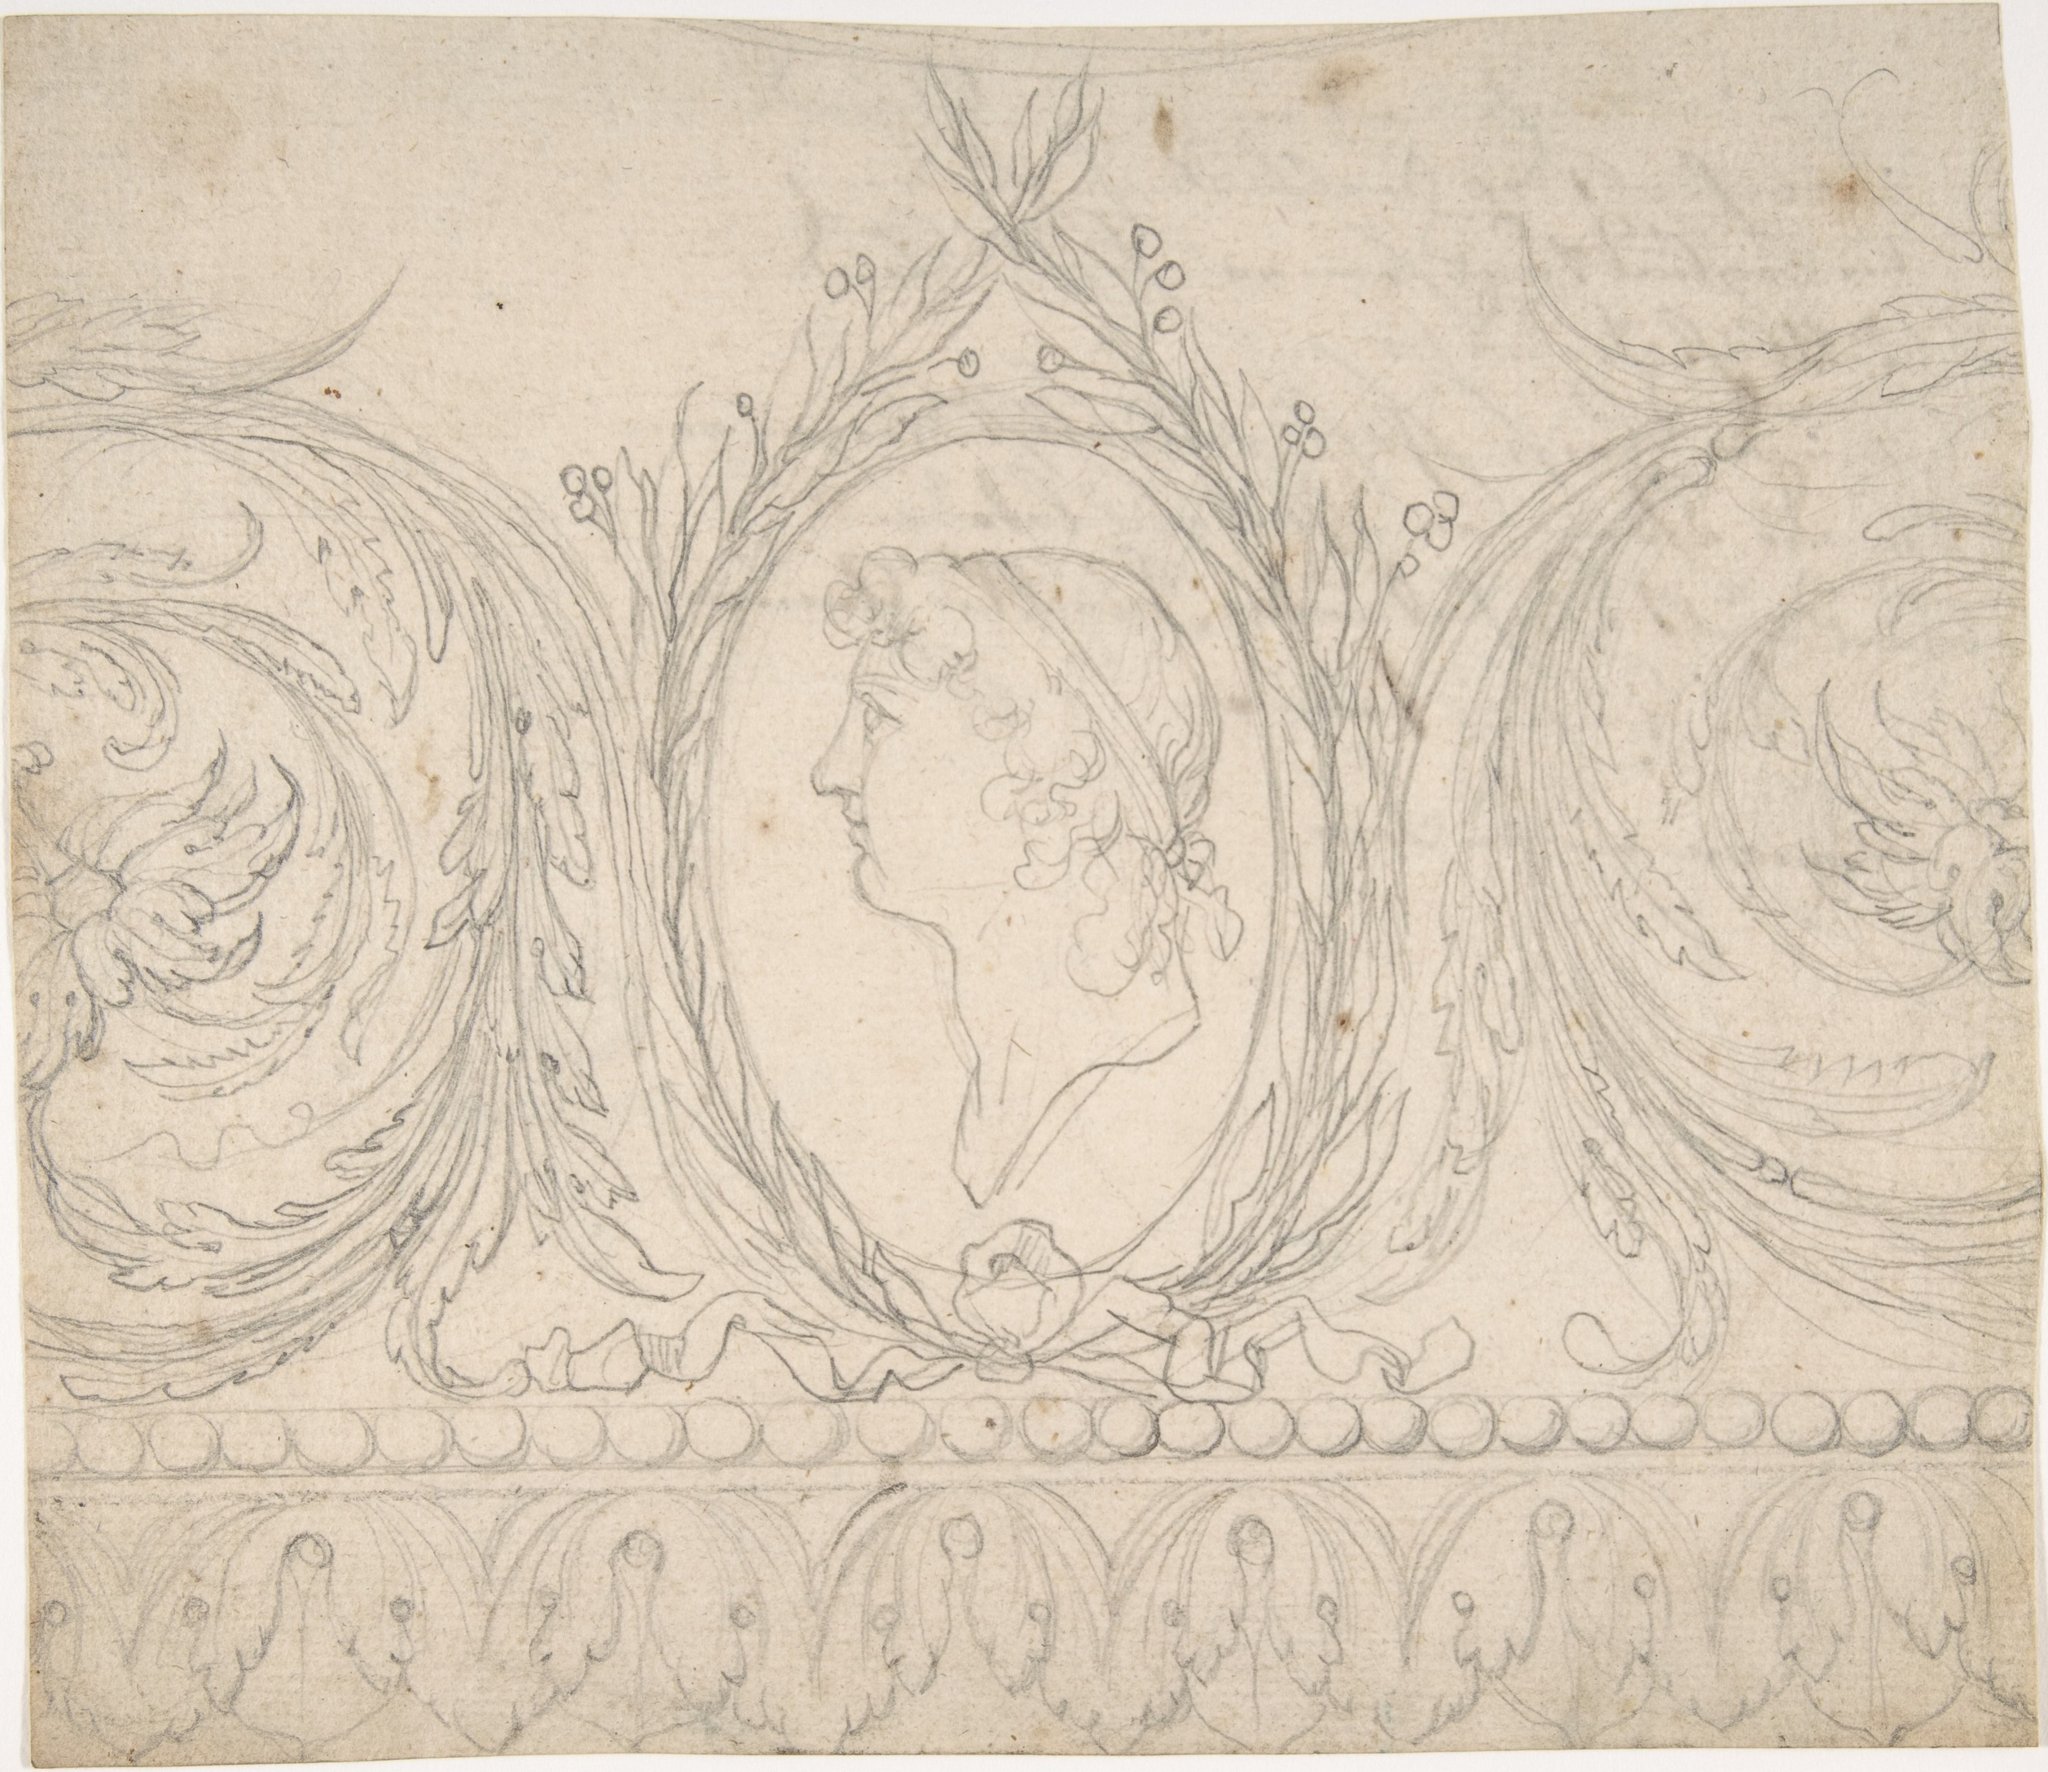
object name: drawing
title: Ornament with Profile Portrait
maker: anonymous, german, 19th century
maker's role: artist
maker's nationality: german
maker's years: 1800-1899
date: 1780-1820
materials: graphite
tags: profiles,women,leaves